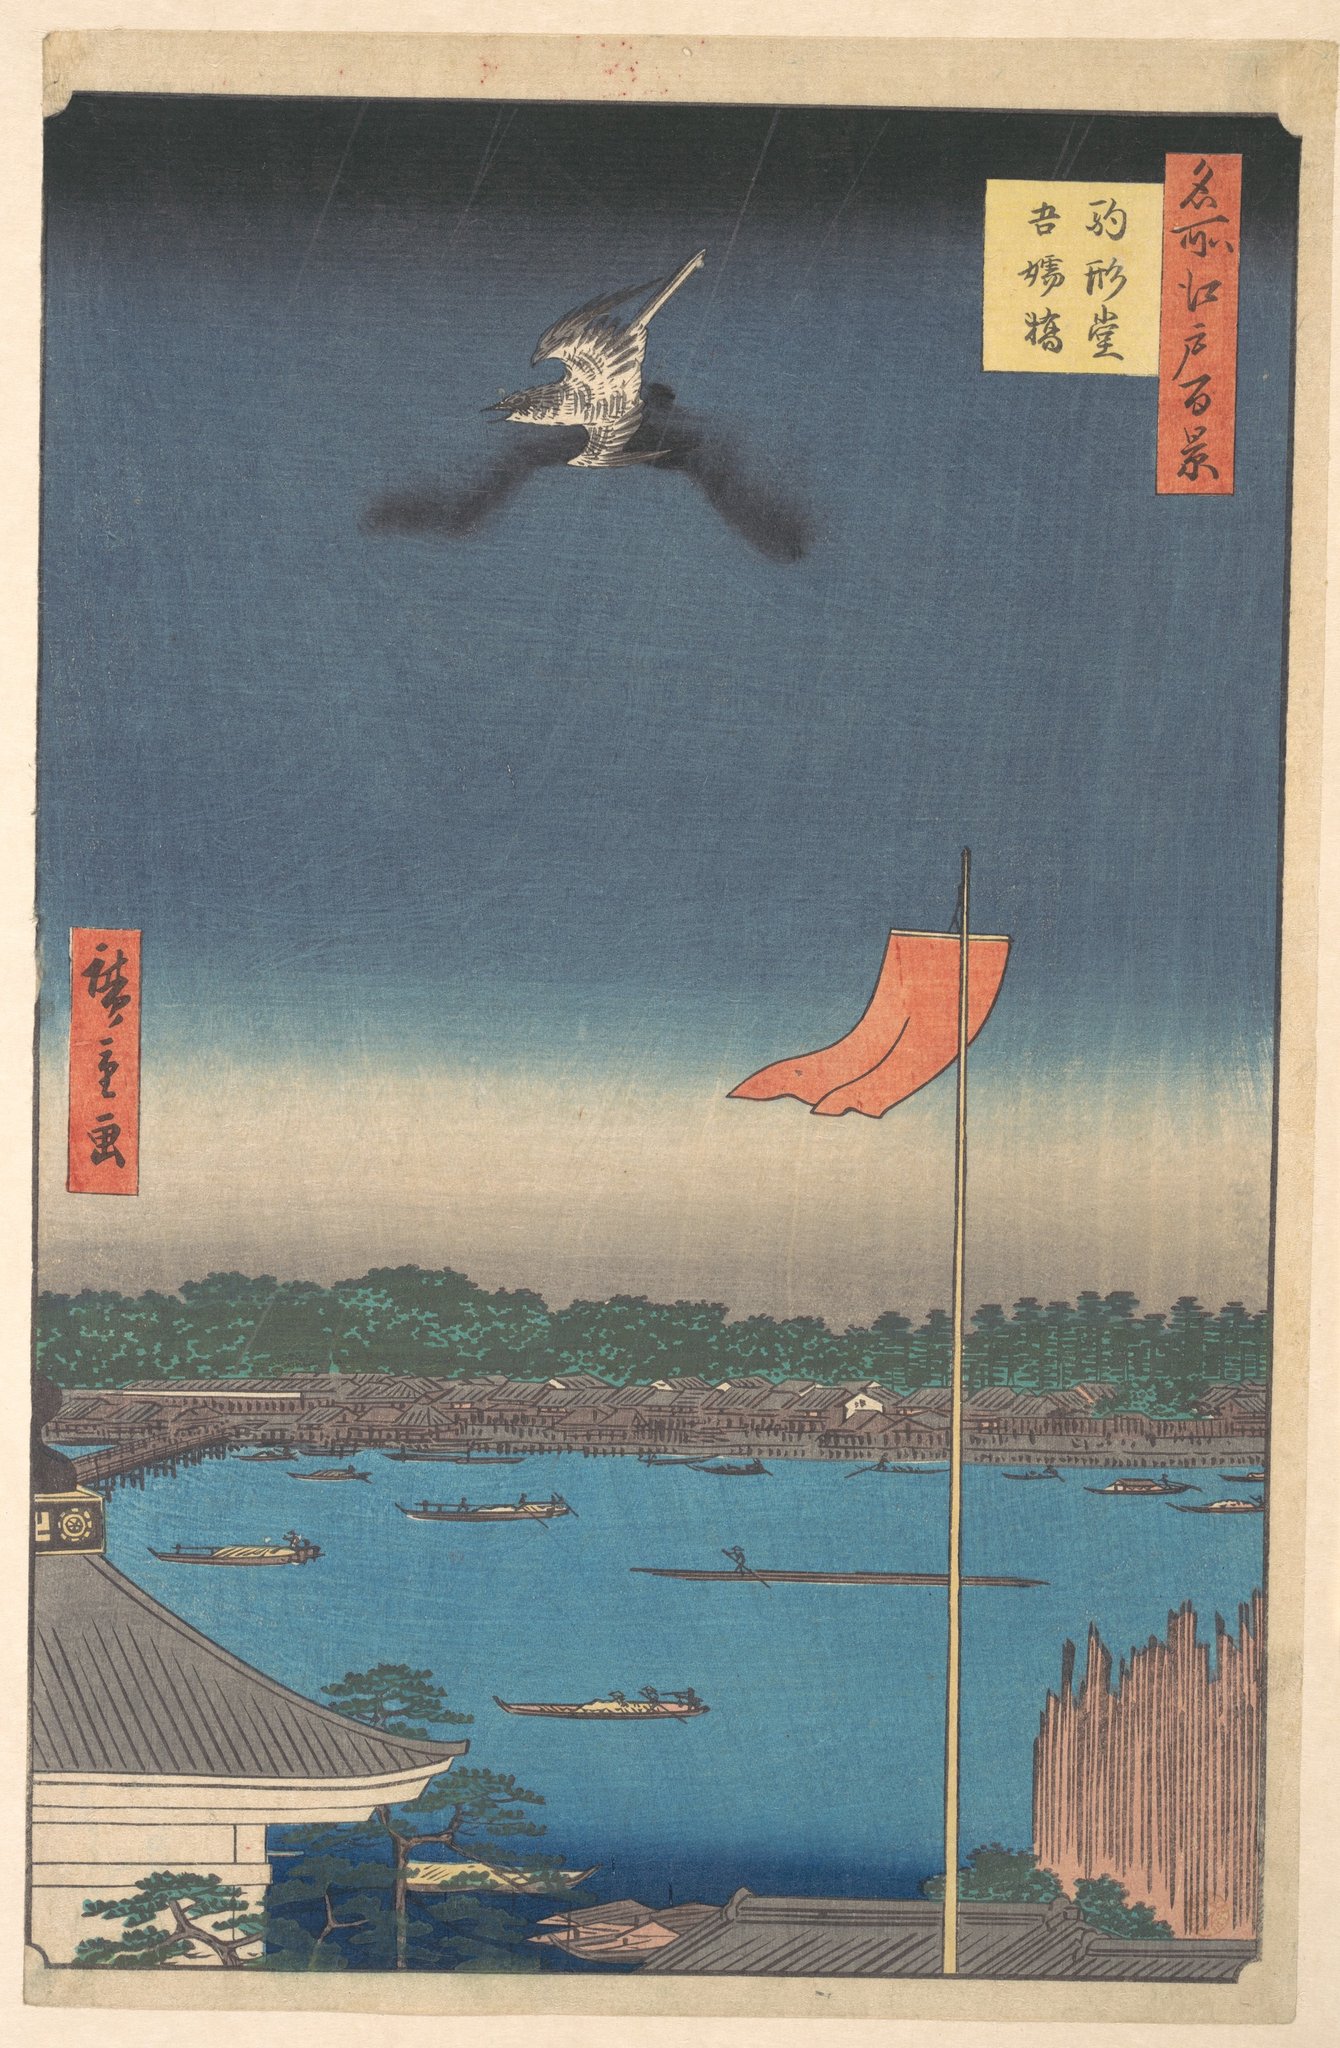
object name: woodblock print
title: “Azuma Bridge from Komagatadō Temple,” from the series One Hundred Famous Views of Edo (Meisho Edo hyakkei, Komagatadō Azumabashi)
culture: japanese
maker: utagawa hiroshige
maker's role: artist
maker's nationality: japanese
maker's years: 1797-1858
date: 1857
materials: ink, paper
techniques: woodblock print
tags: houses,rivers,trees,flags,boats